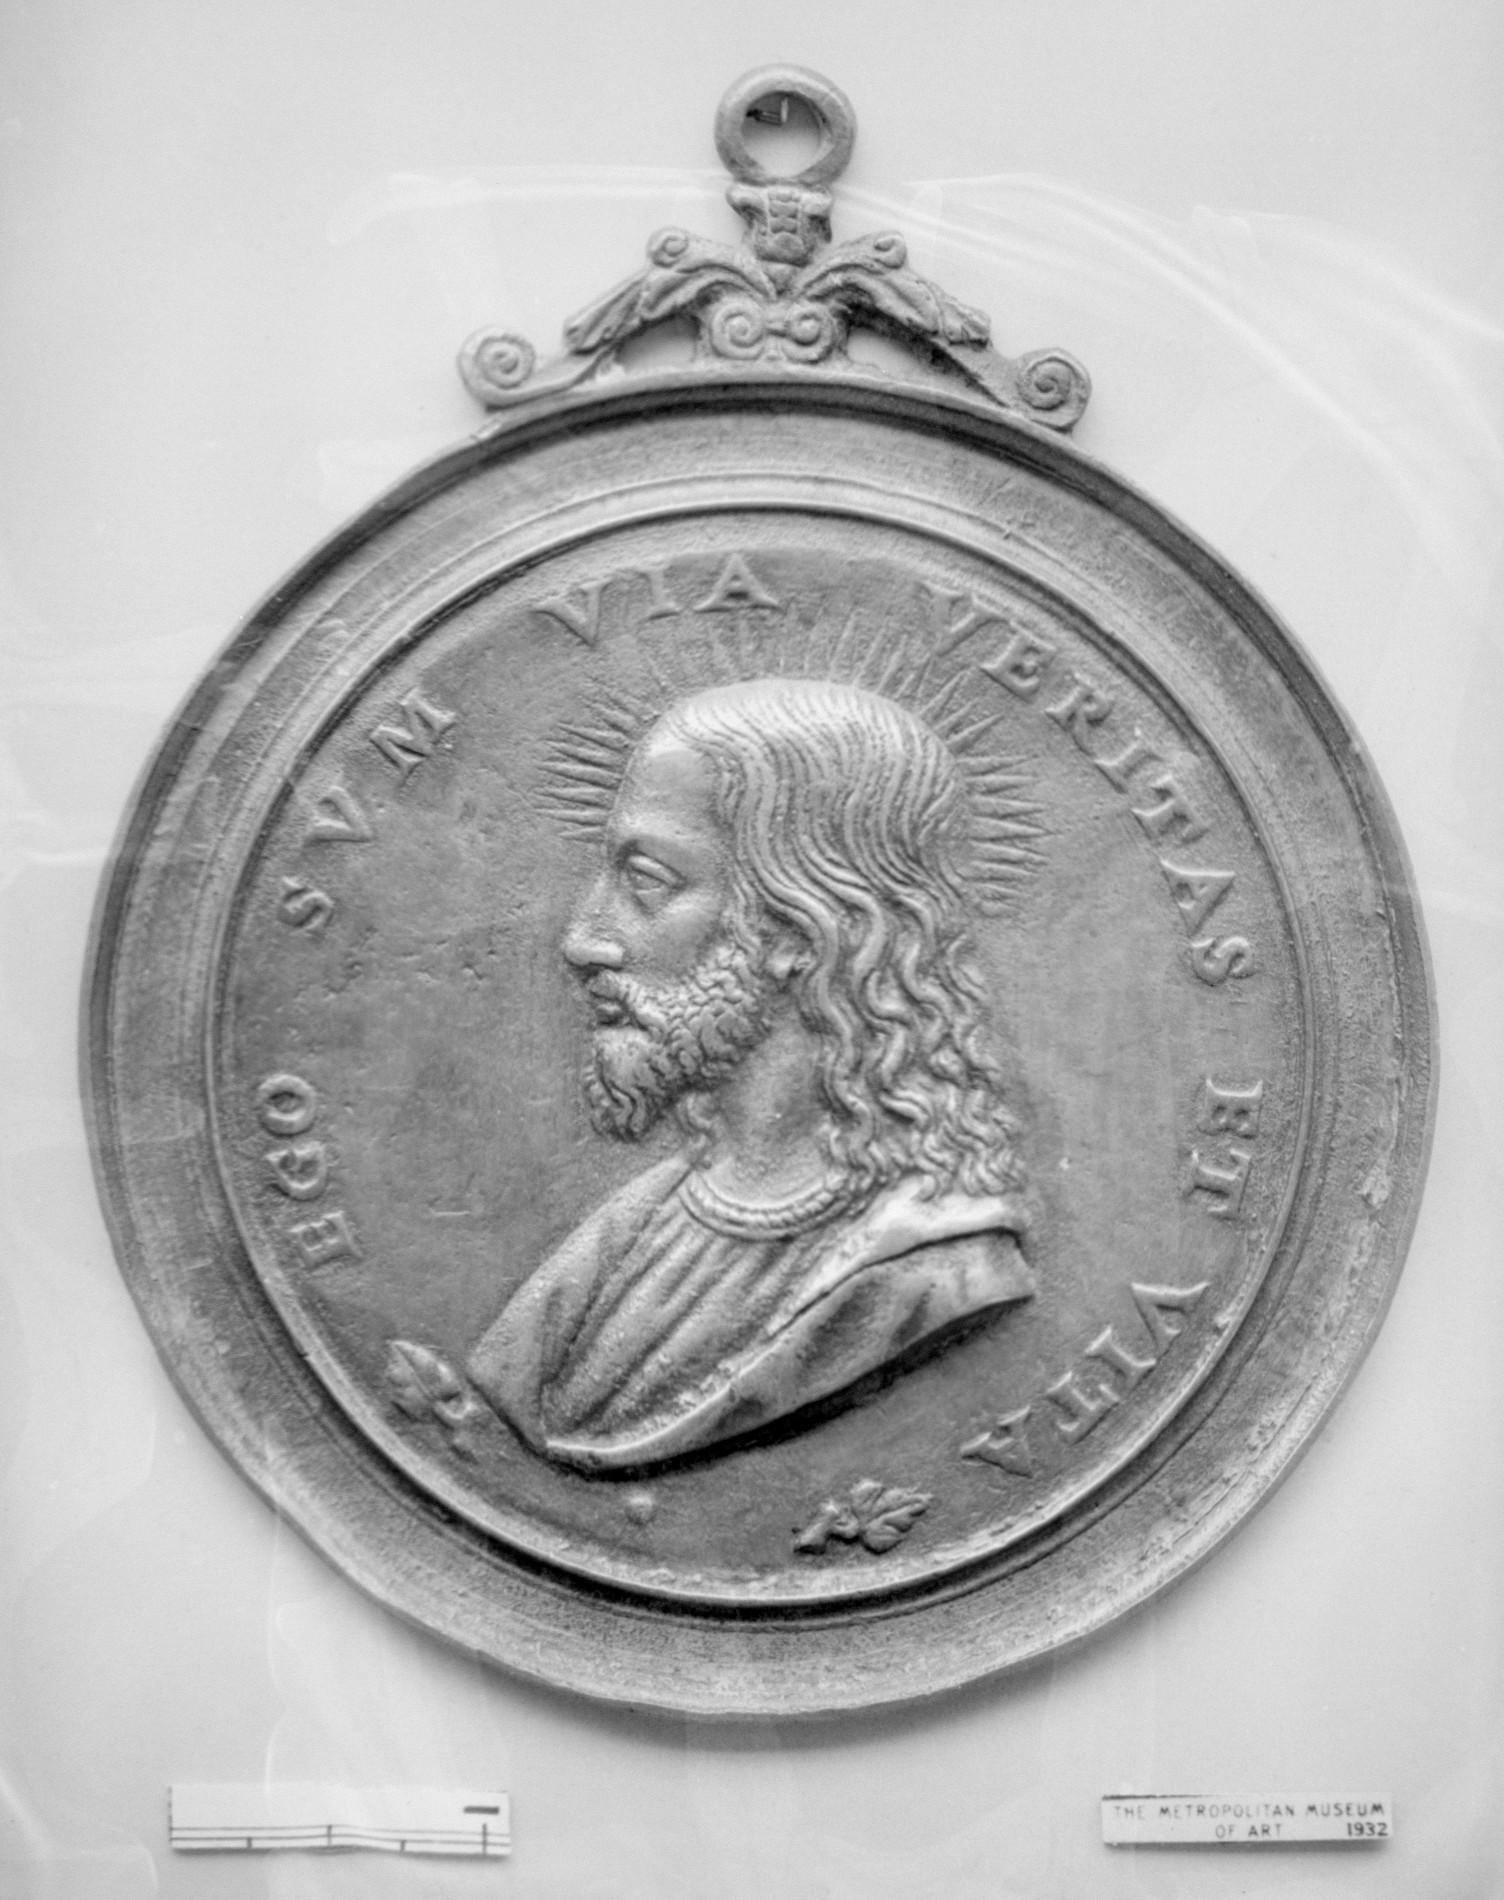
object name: medal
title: Head of Christ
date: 1567-1600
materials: bronze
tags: profiles,christ